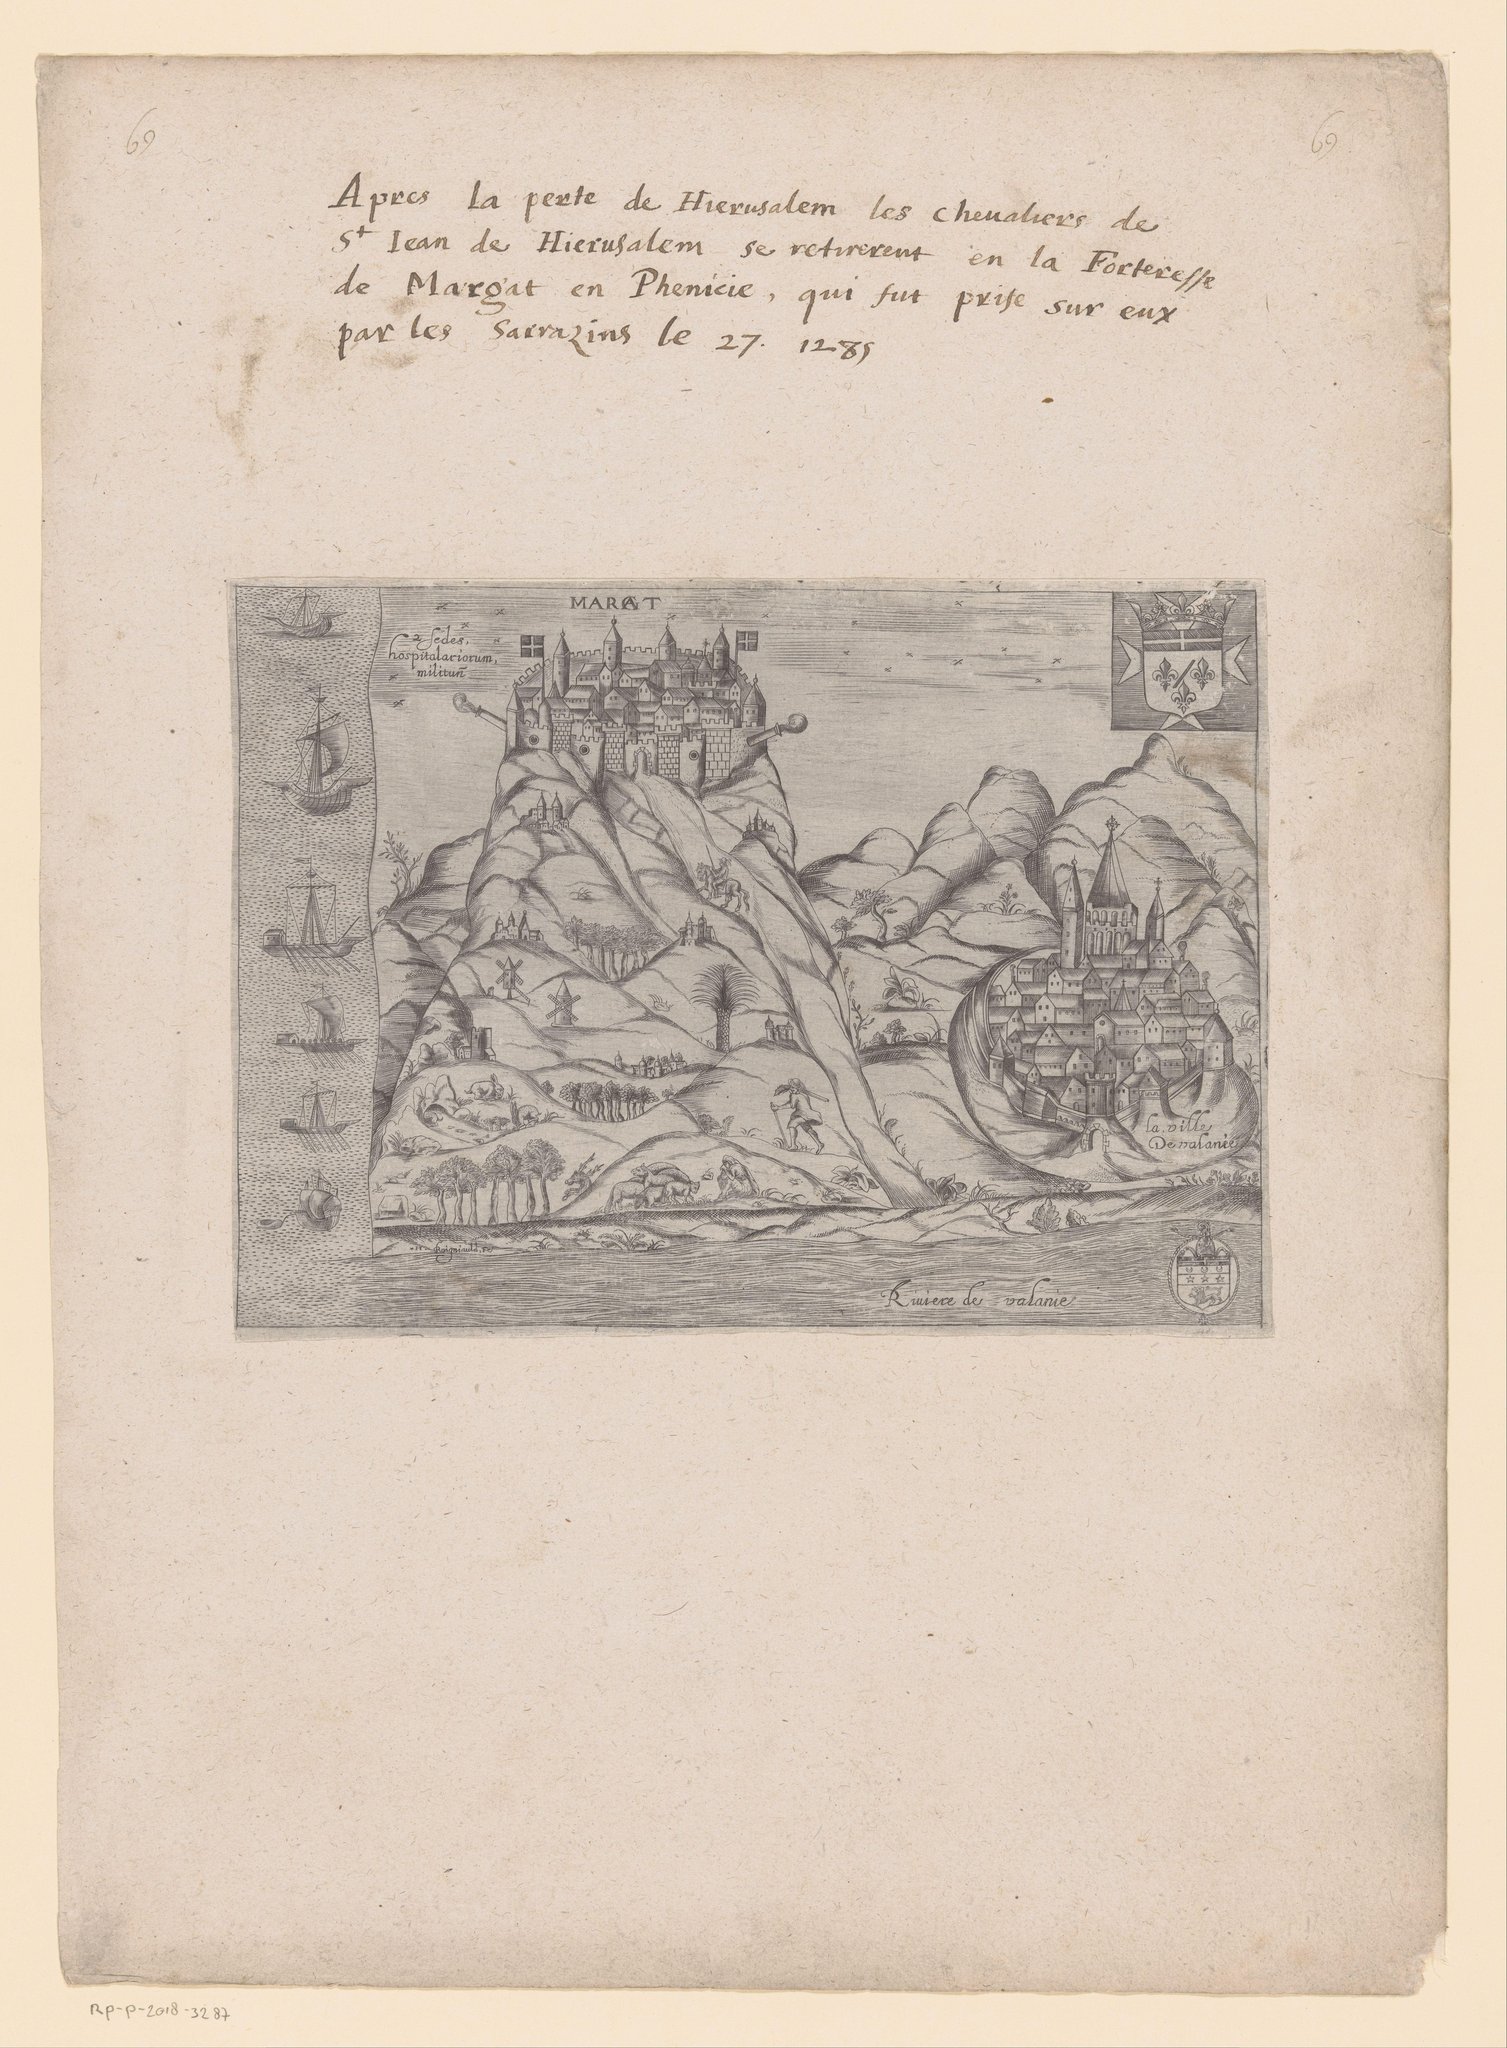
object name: print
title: Margat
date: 1629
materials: paper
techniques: etching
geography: paris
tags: landscape with tower or castle, prospect of city, town panorama, silhouette of city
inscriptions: collector's mark: Lugt 2228, inscription: ‘Apres la perte de Hierusalem les chevaliers de st. Jean de Hierusalem se retirerent en la Forteresse de Margat en Phenicie, qui fut prise sur eux par les Sarvazins le 27 1285’, inscription: ‘69’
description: Gezicht op de kruisvaardersburcht Margat (Marqab) en de stad Valanie. Rechtsboven een wapenschild. Links boten in het water.